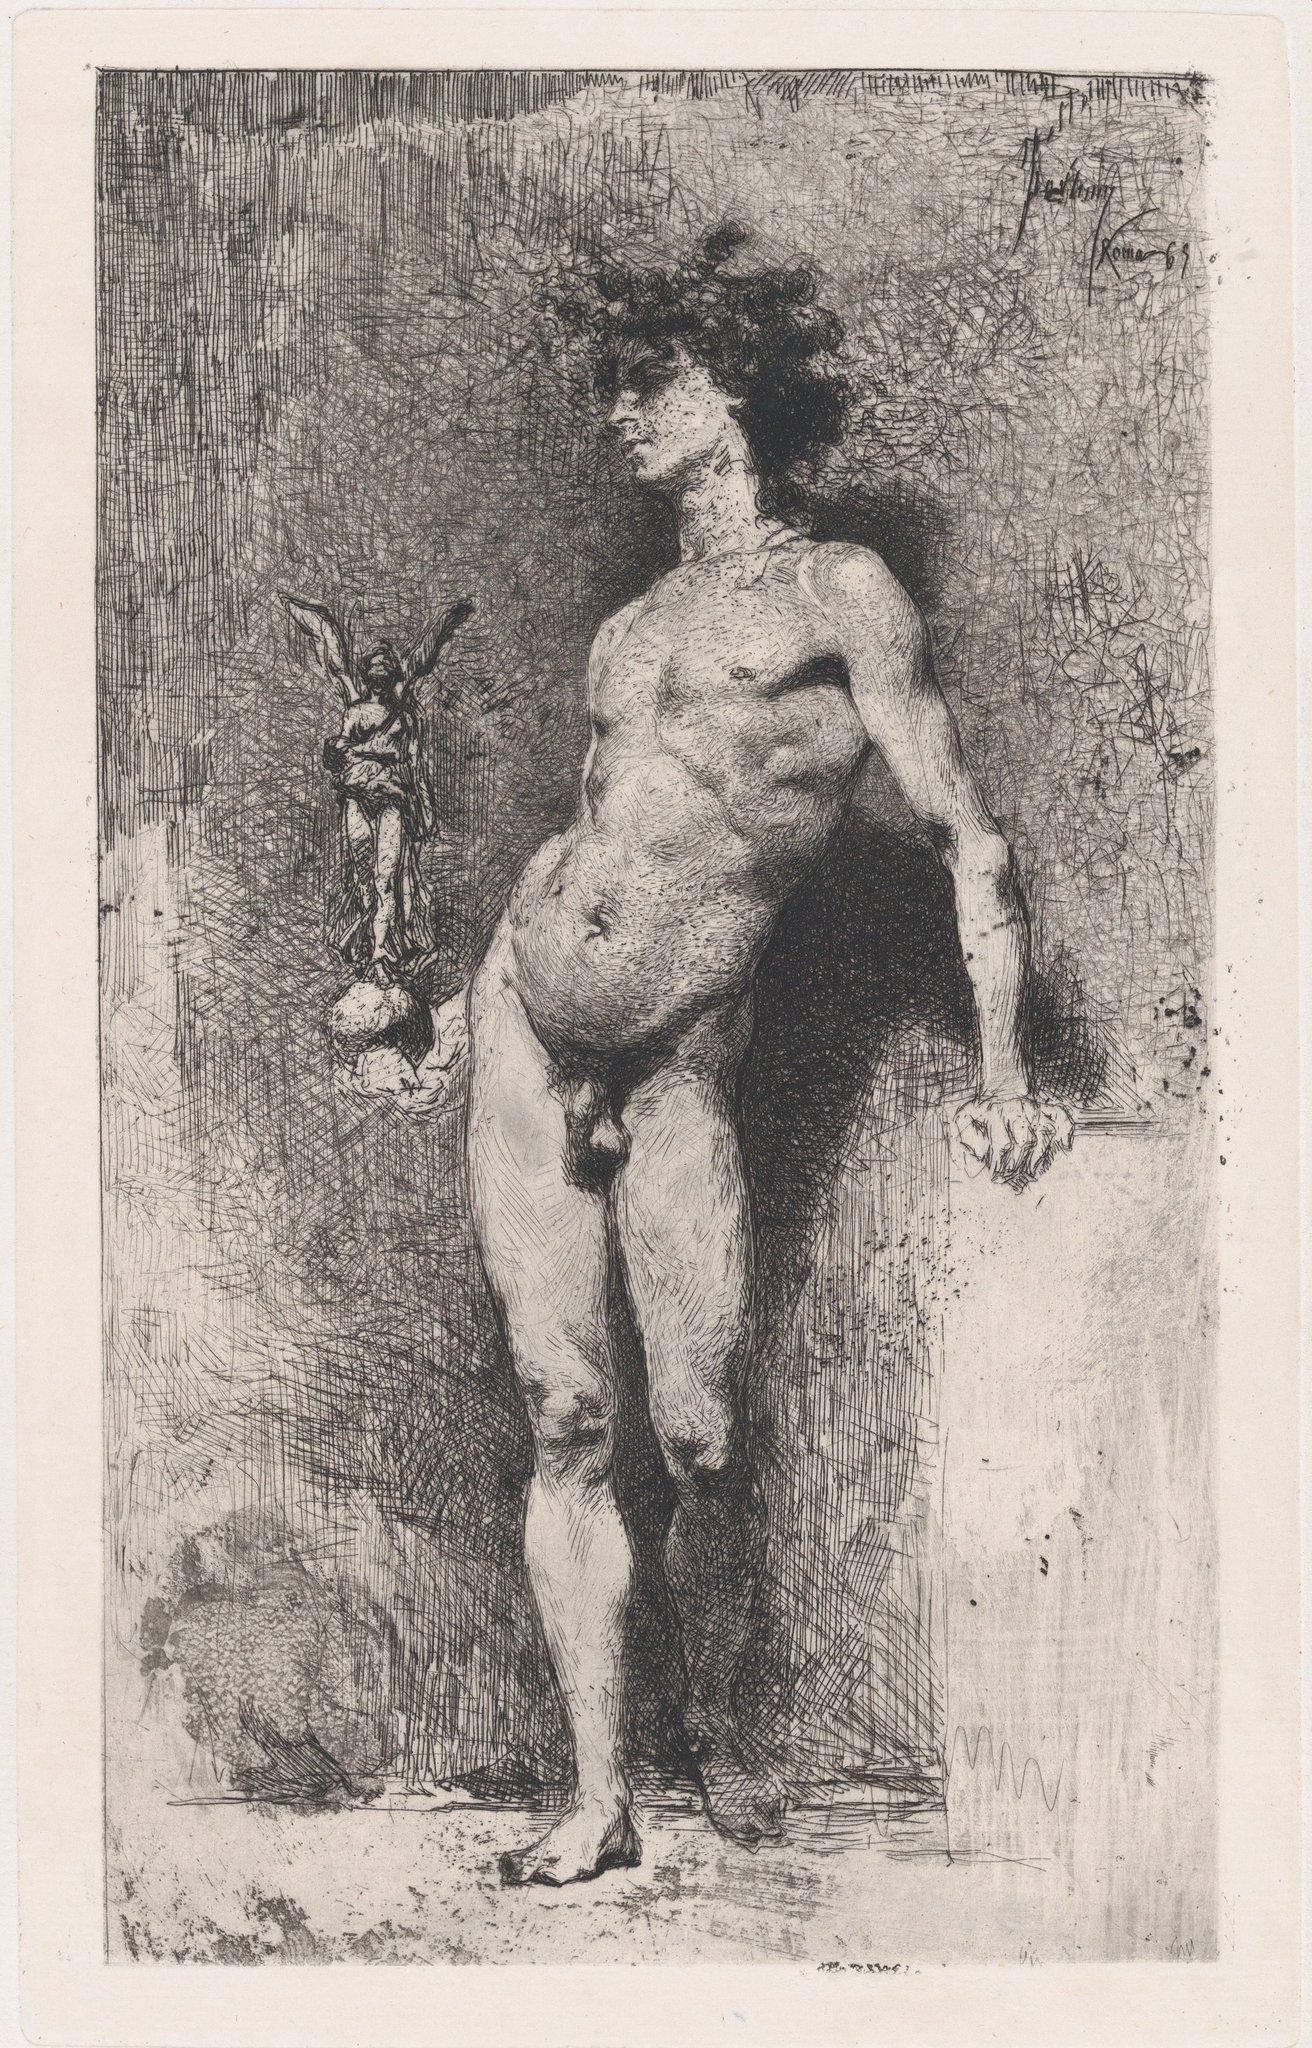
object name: print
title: Victory: a naked youth standing facing left holding a statue of winged Victory in his right hand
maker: mariano fortuny, 1838–1874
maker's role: artist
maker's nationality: spanish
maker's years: 1838-1874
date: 1869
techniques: etching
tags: male nudes